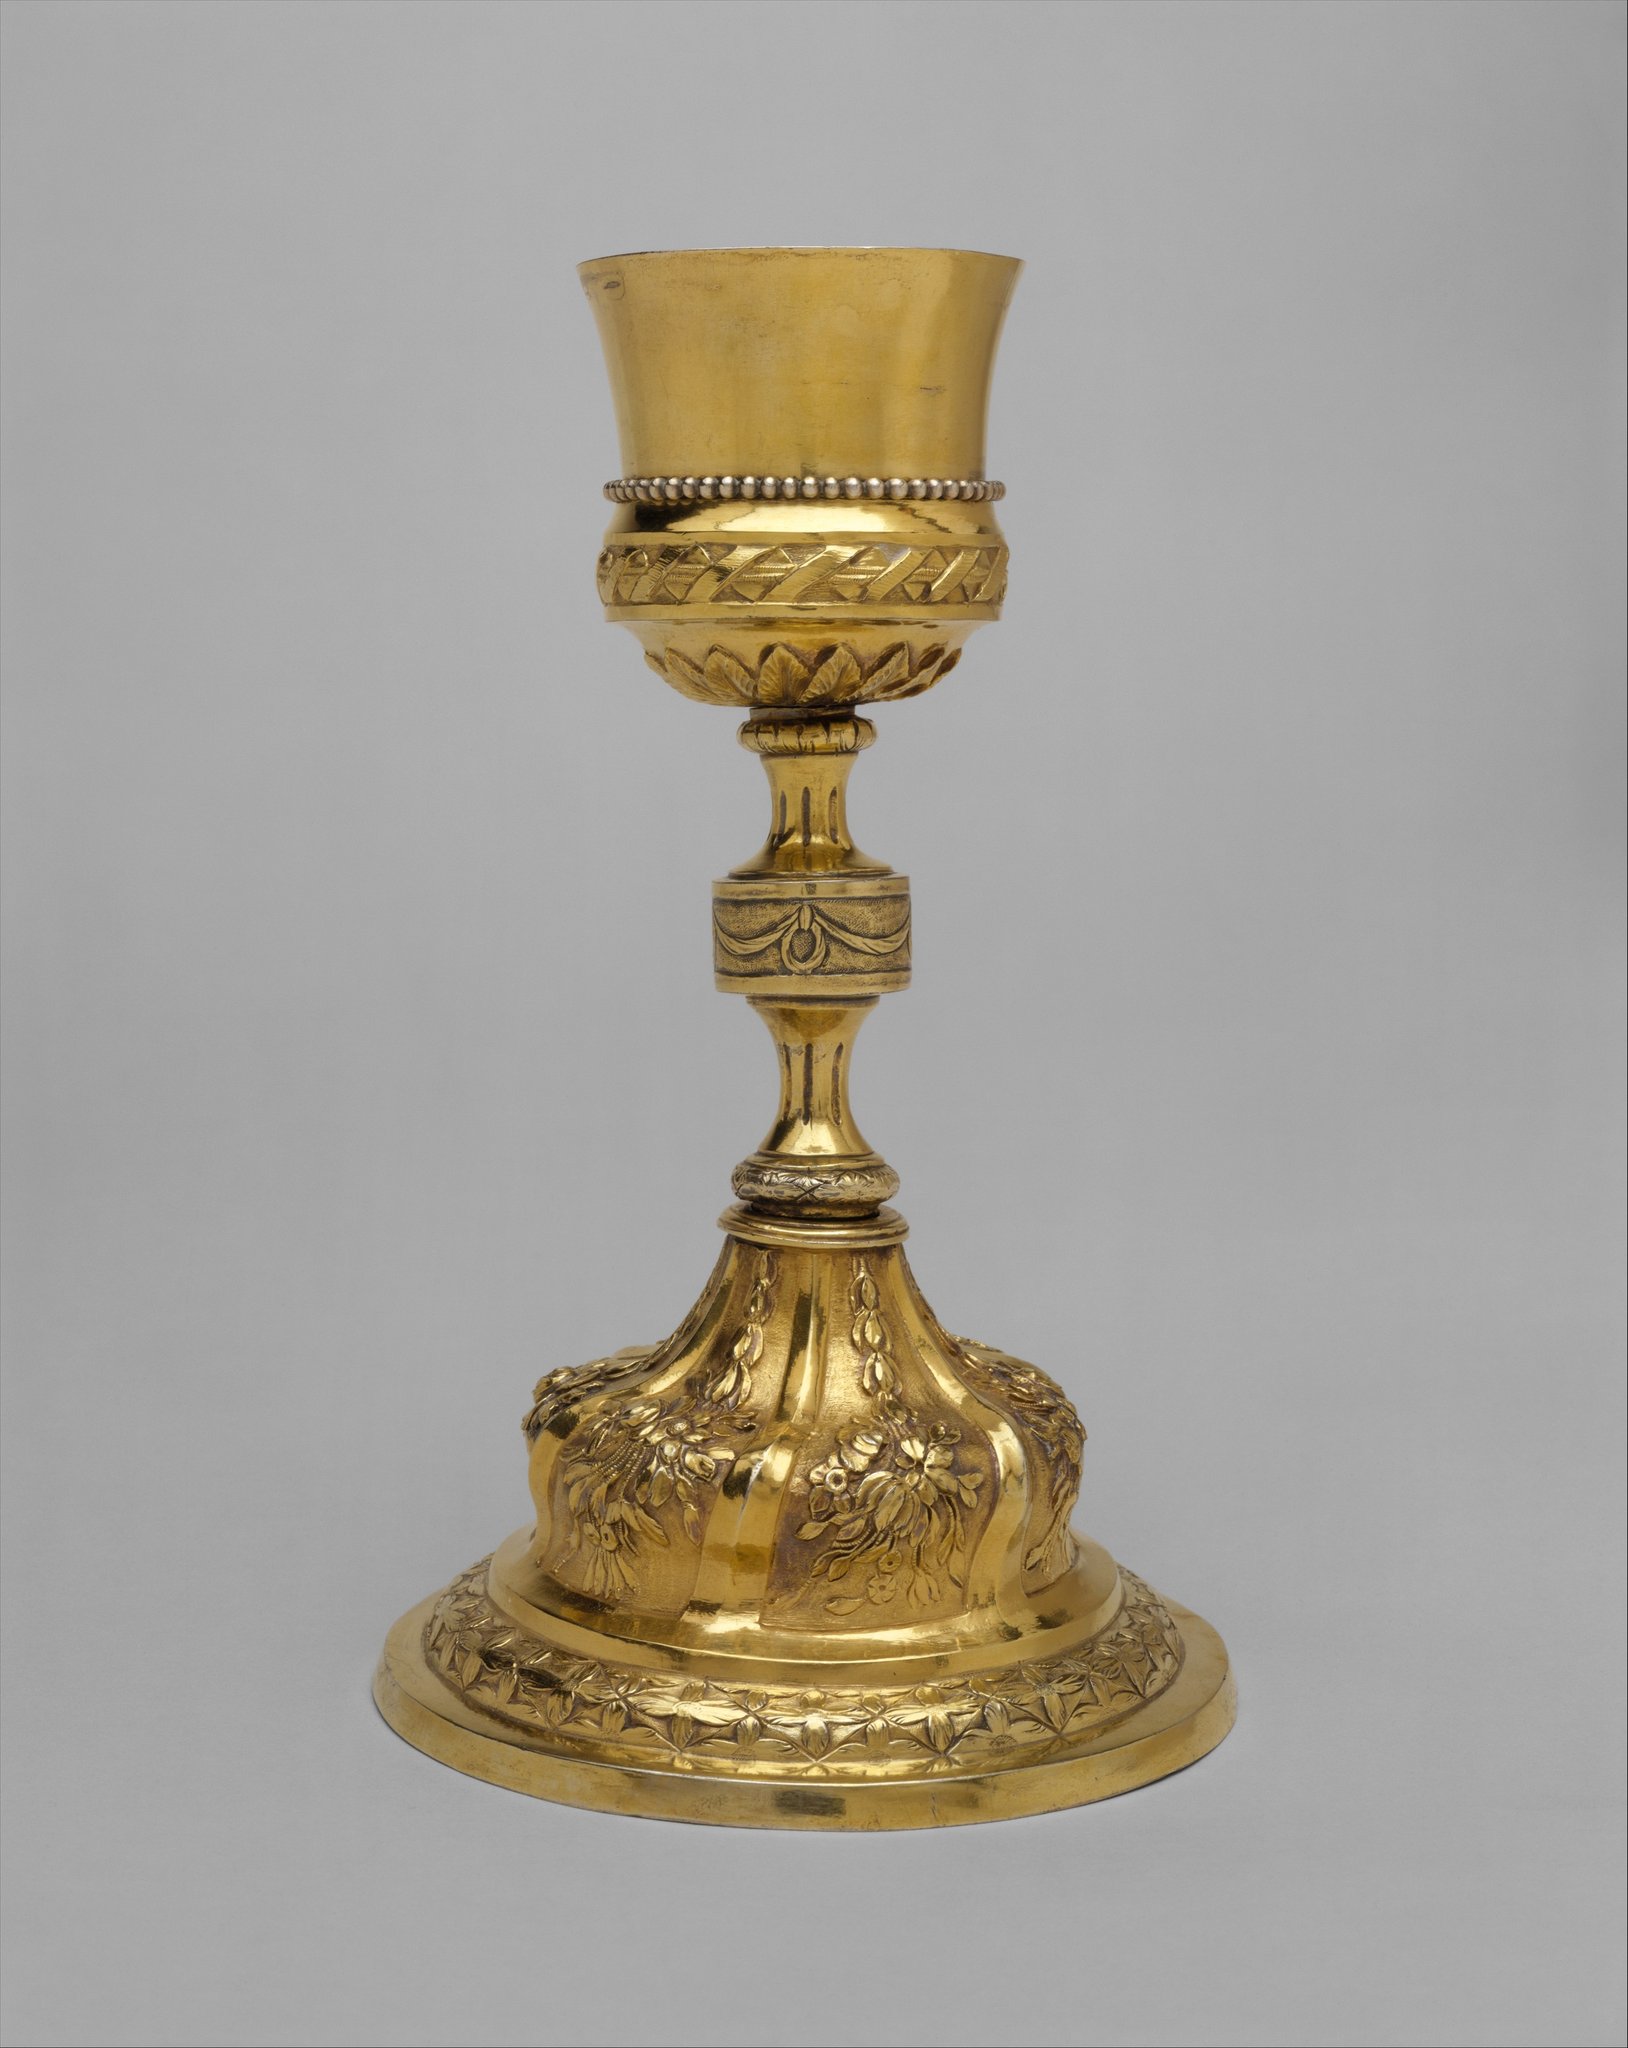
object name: chalice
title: Chalice and Paten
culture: mexican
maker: antonio forcada y la plaza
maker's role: maker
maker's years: 1790-1818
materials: silver gilt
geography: spain